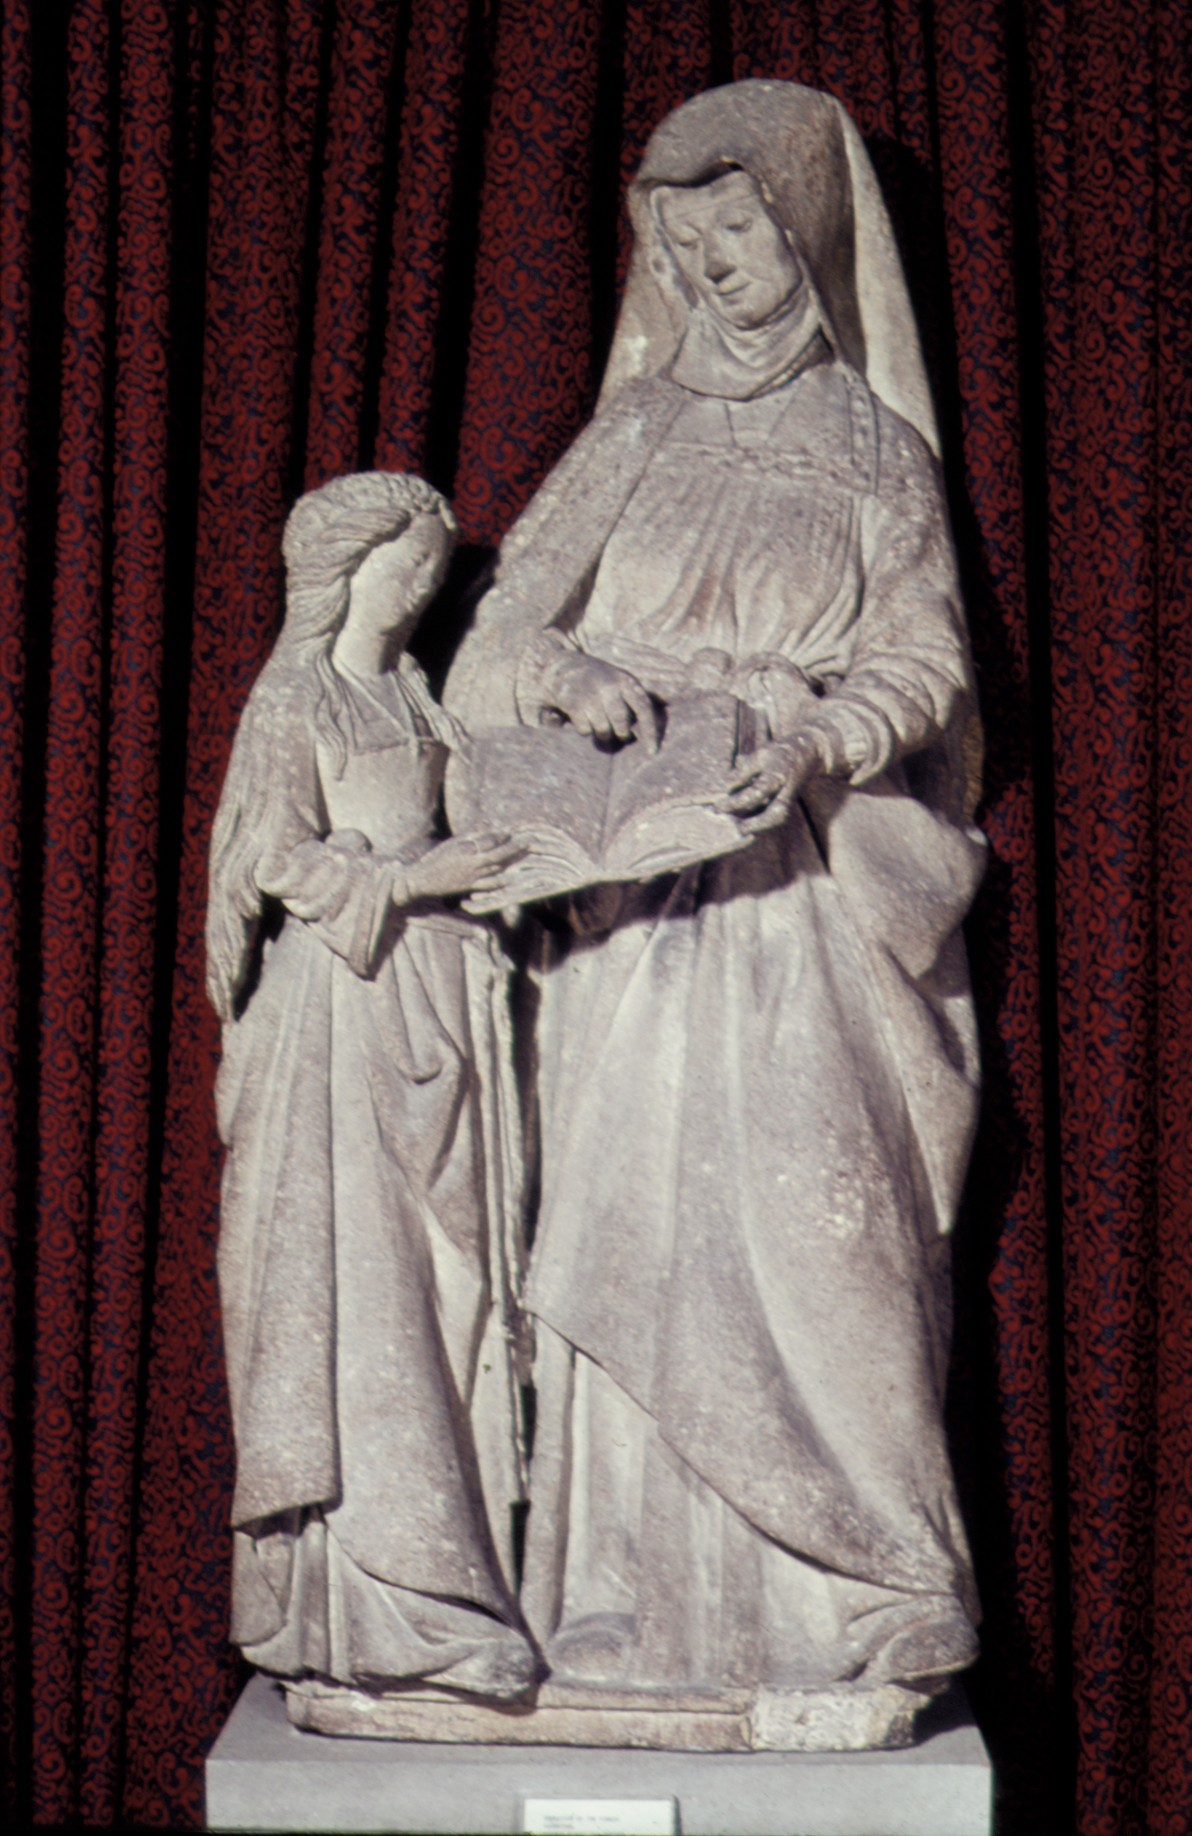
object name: sculpture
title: Education of the Virgin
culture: french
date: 1510-1520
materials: stone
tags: books,saint anne,virgin mary